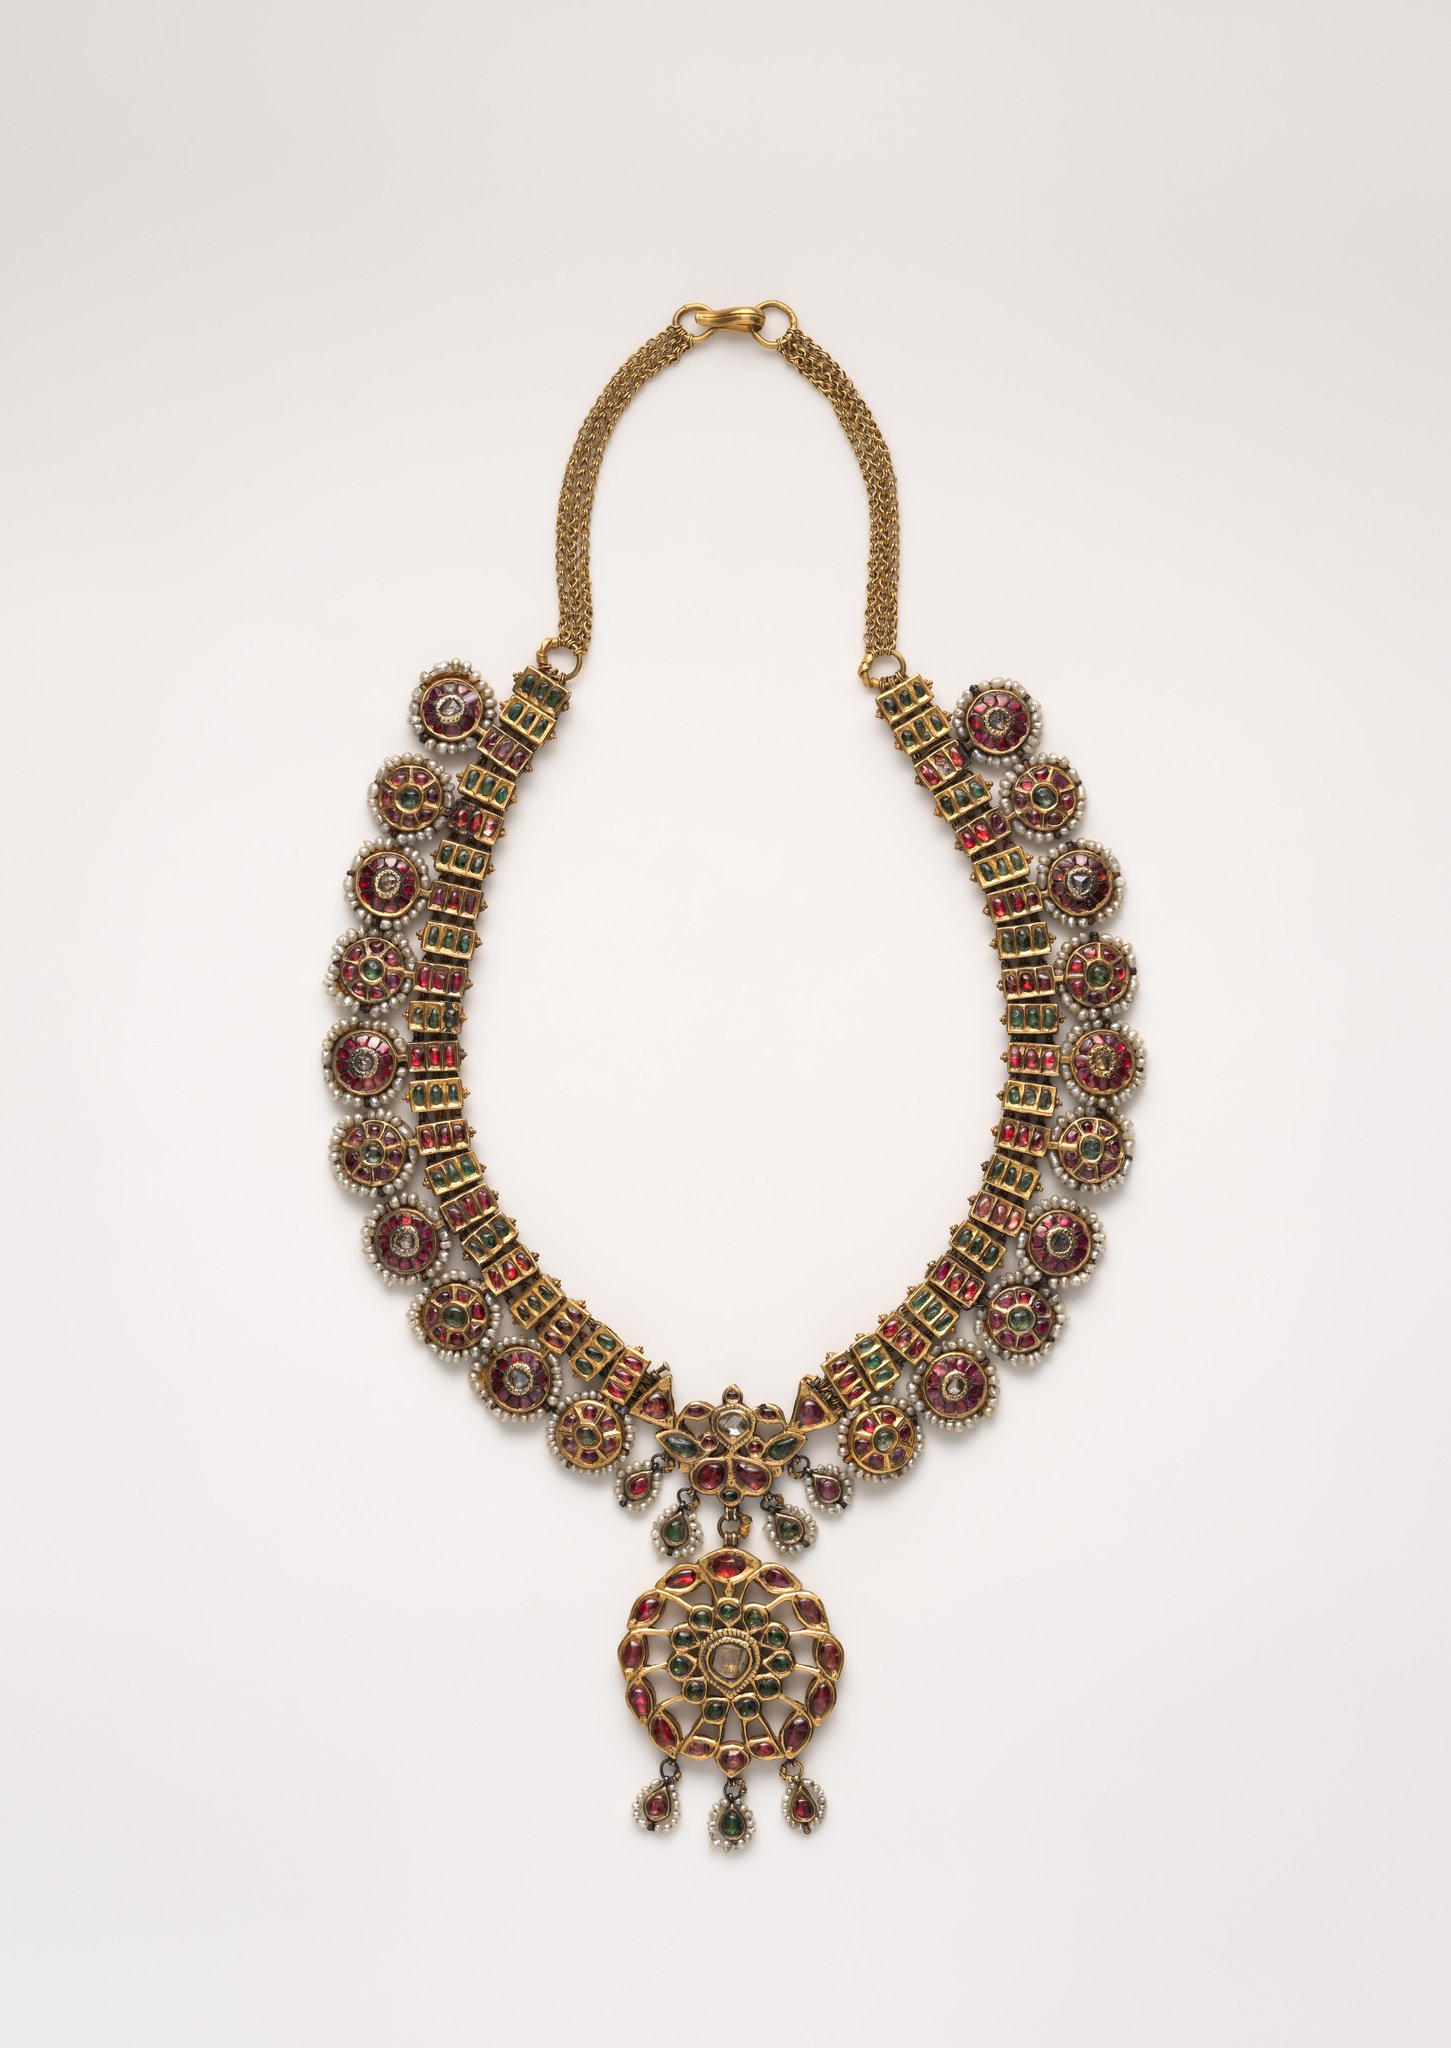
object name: necklace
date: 1701-1900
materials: diamond, gemstone, gold, pearl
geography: india